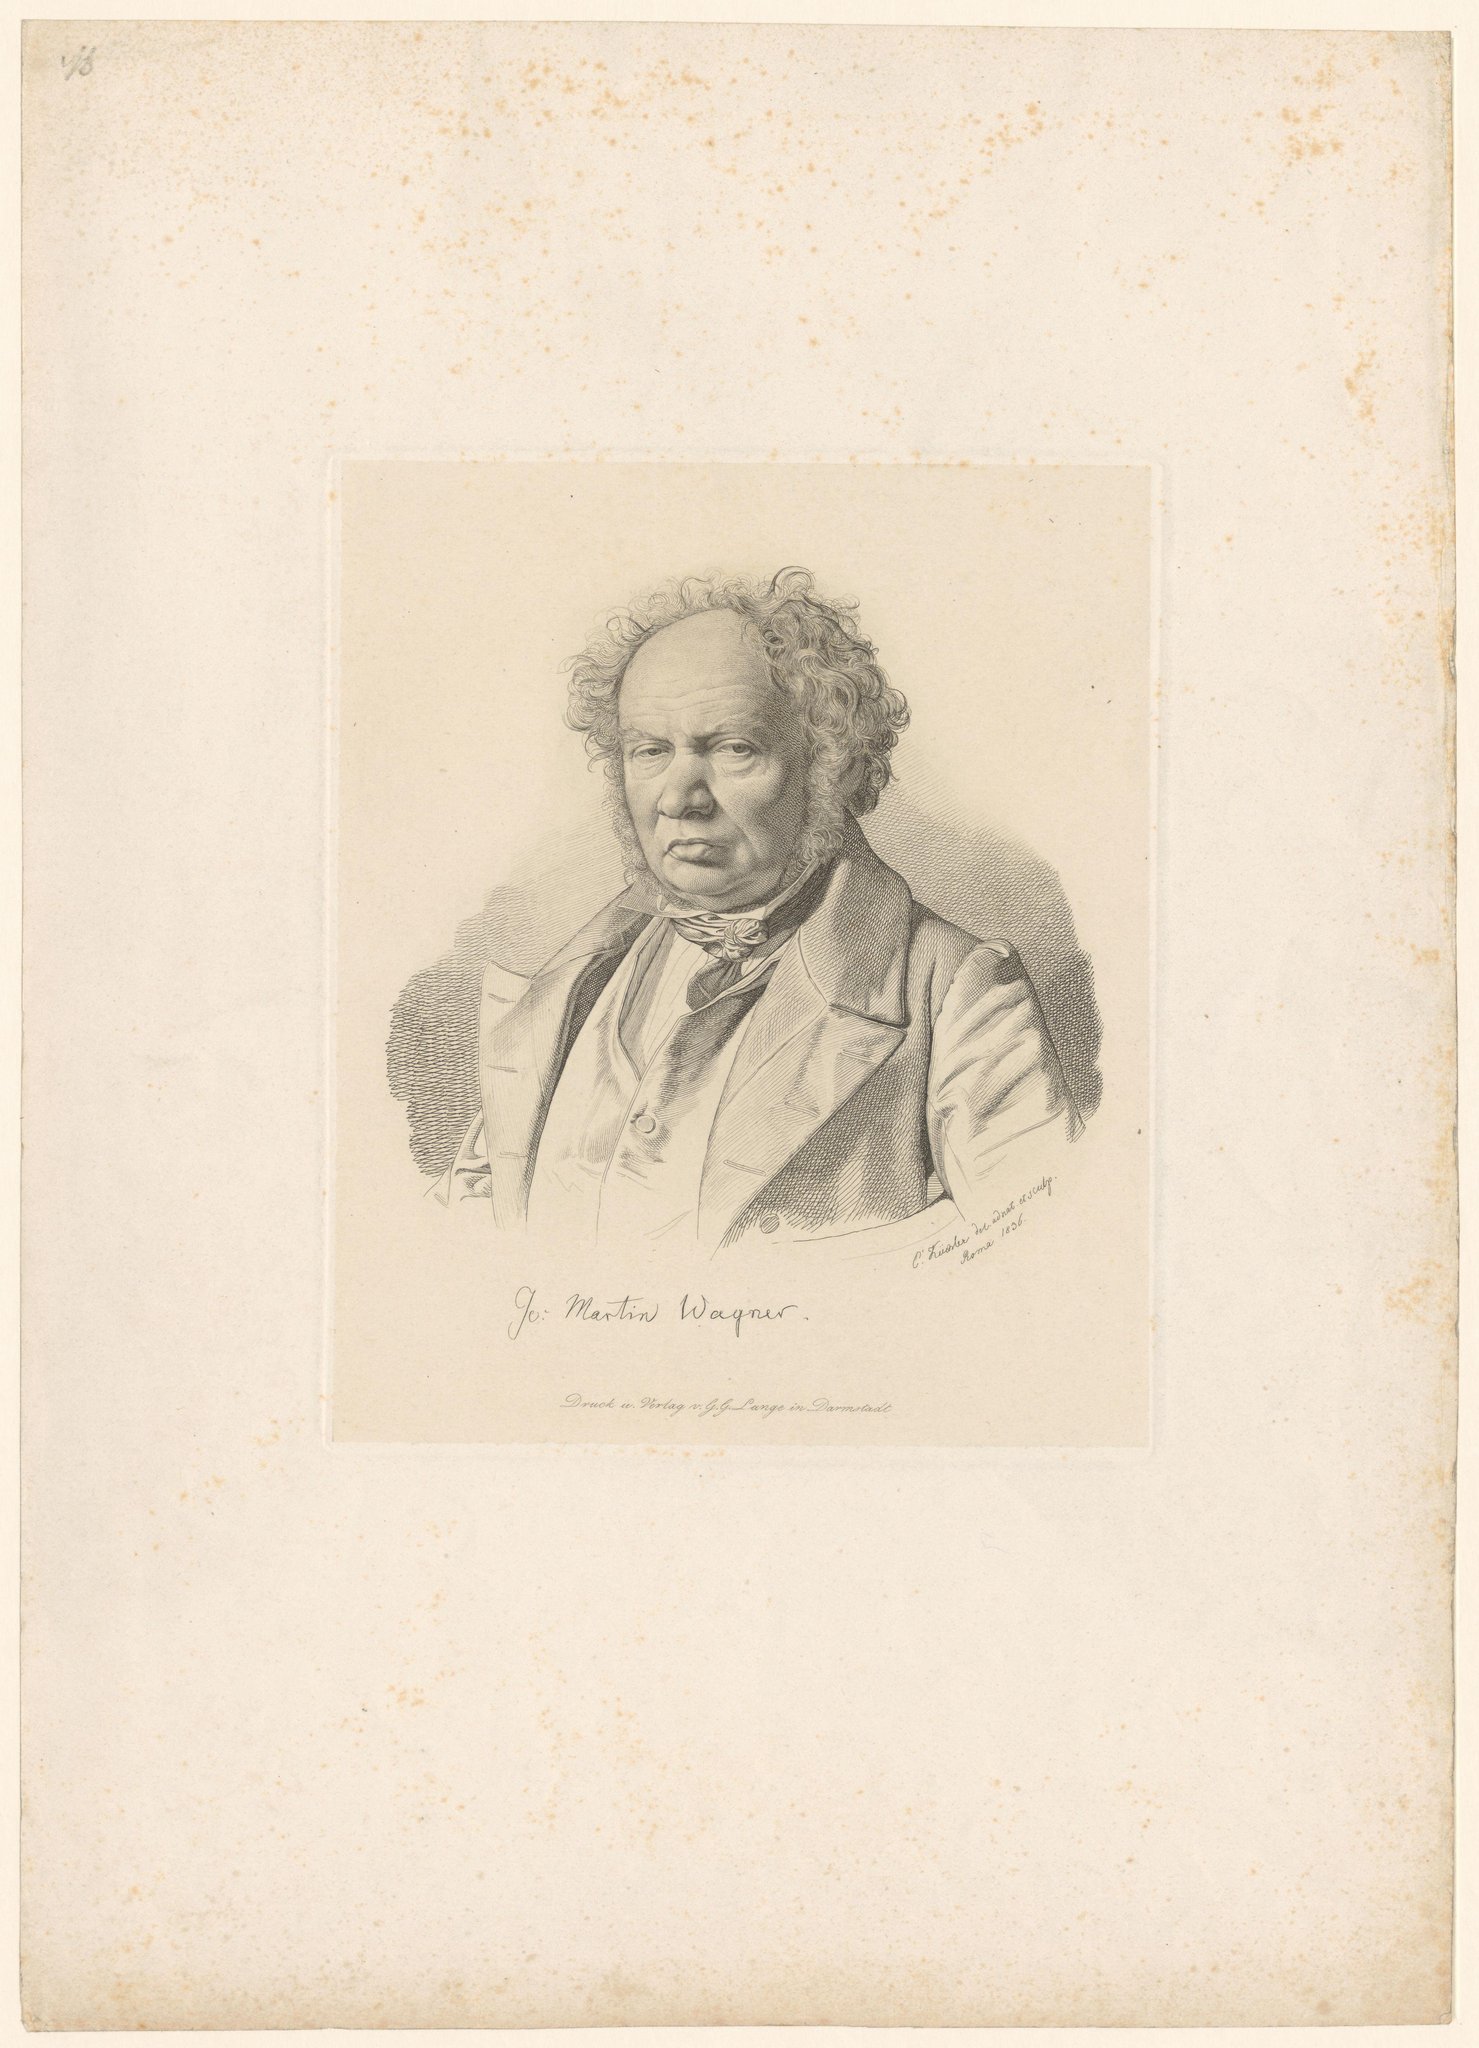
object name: print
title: Portret van Johann Martin von Wagner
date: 1836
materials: paper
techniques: etching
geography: rome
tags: rome, draughtsman, sculptor, conservator, johann martin wagner, historical persons, portrait, self-portrait of graphic artist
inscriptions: collector's mark: Lugt 2228